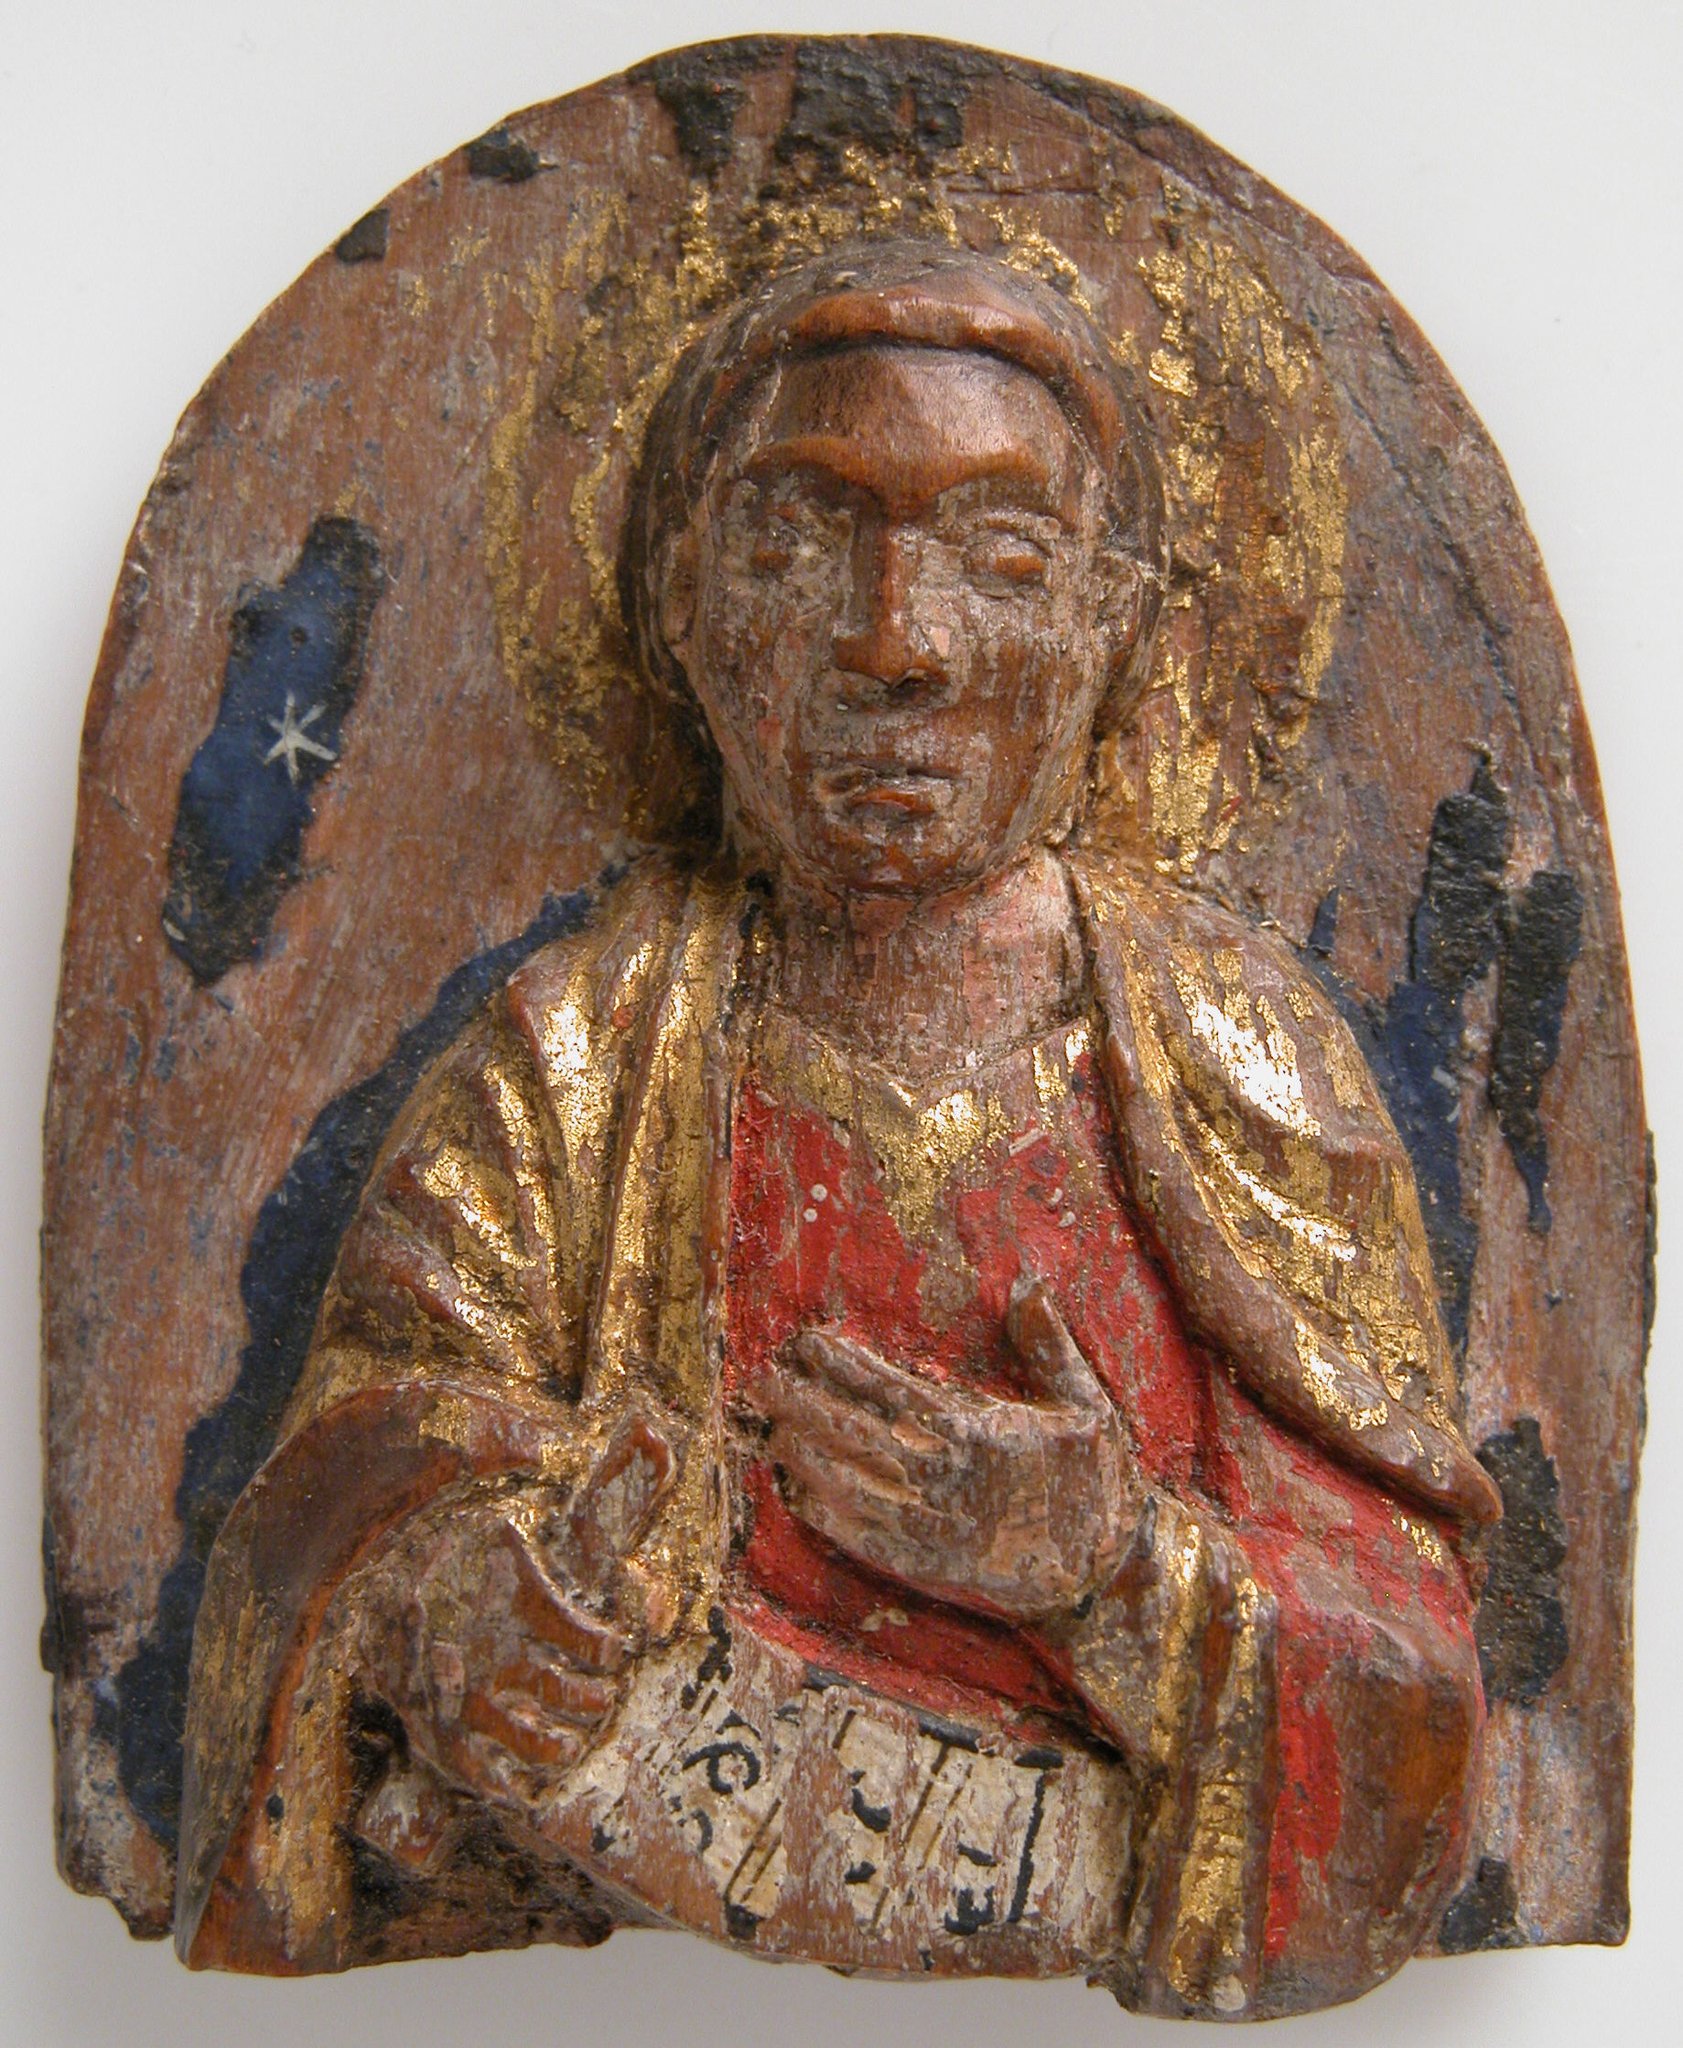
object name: relief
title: Miniature Relief of Hebrew Prophet Daniel (?) with Scroll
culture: german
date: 1200-1225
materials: wood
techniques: gilding, polychromy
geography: germany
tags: scrolls